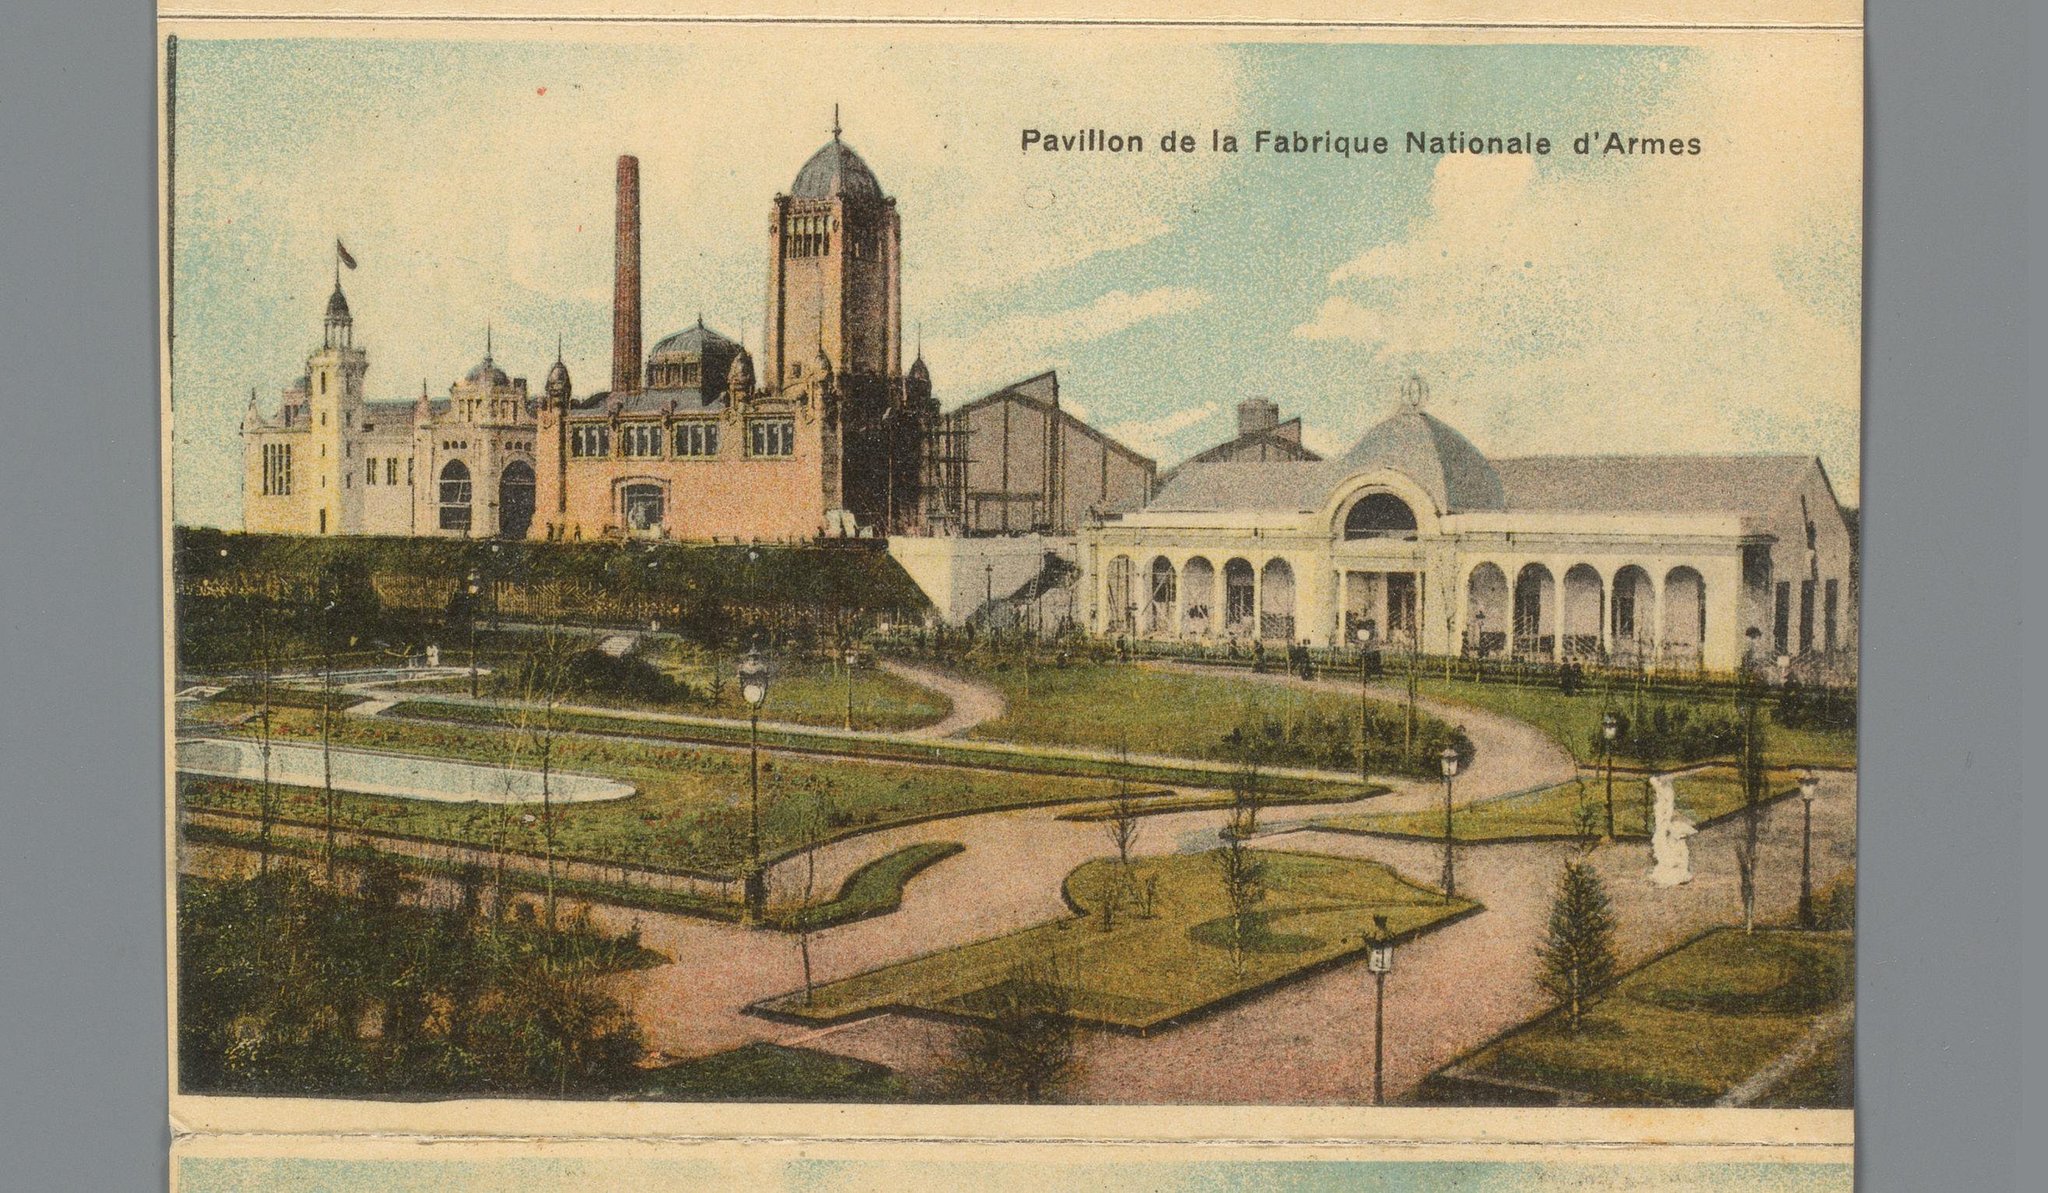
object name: photomechanical print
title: Pavillon de la Fabrique Nationale d'Armes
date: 1910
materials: cardboard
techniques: photograph, lithograph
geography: brussels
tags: park, world fair, world exhibition, brussels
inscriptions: date